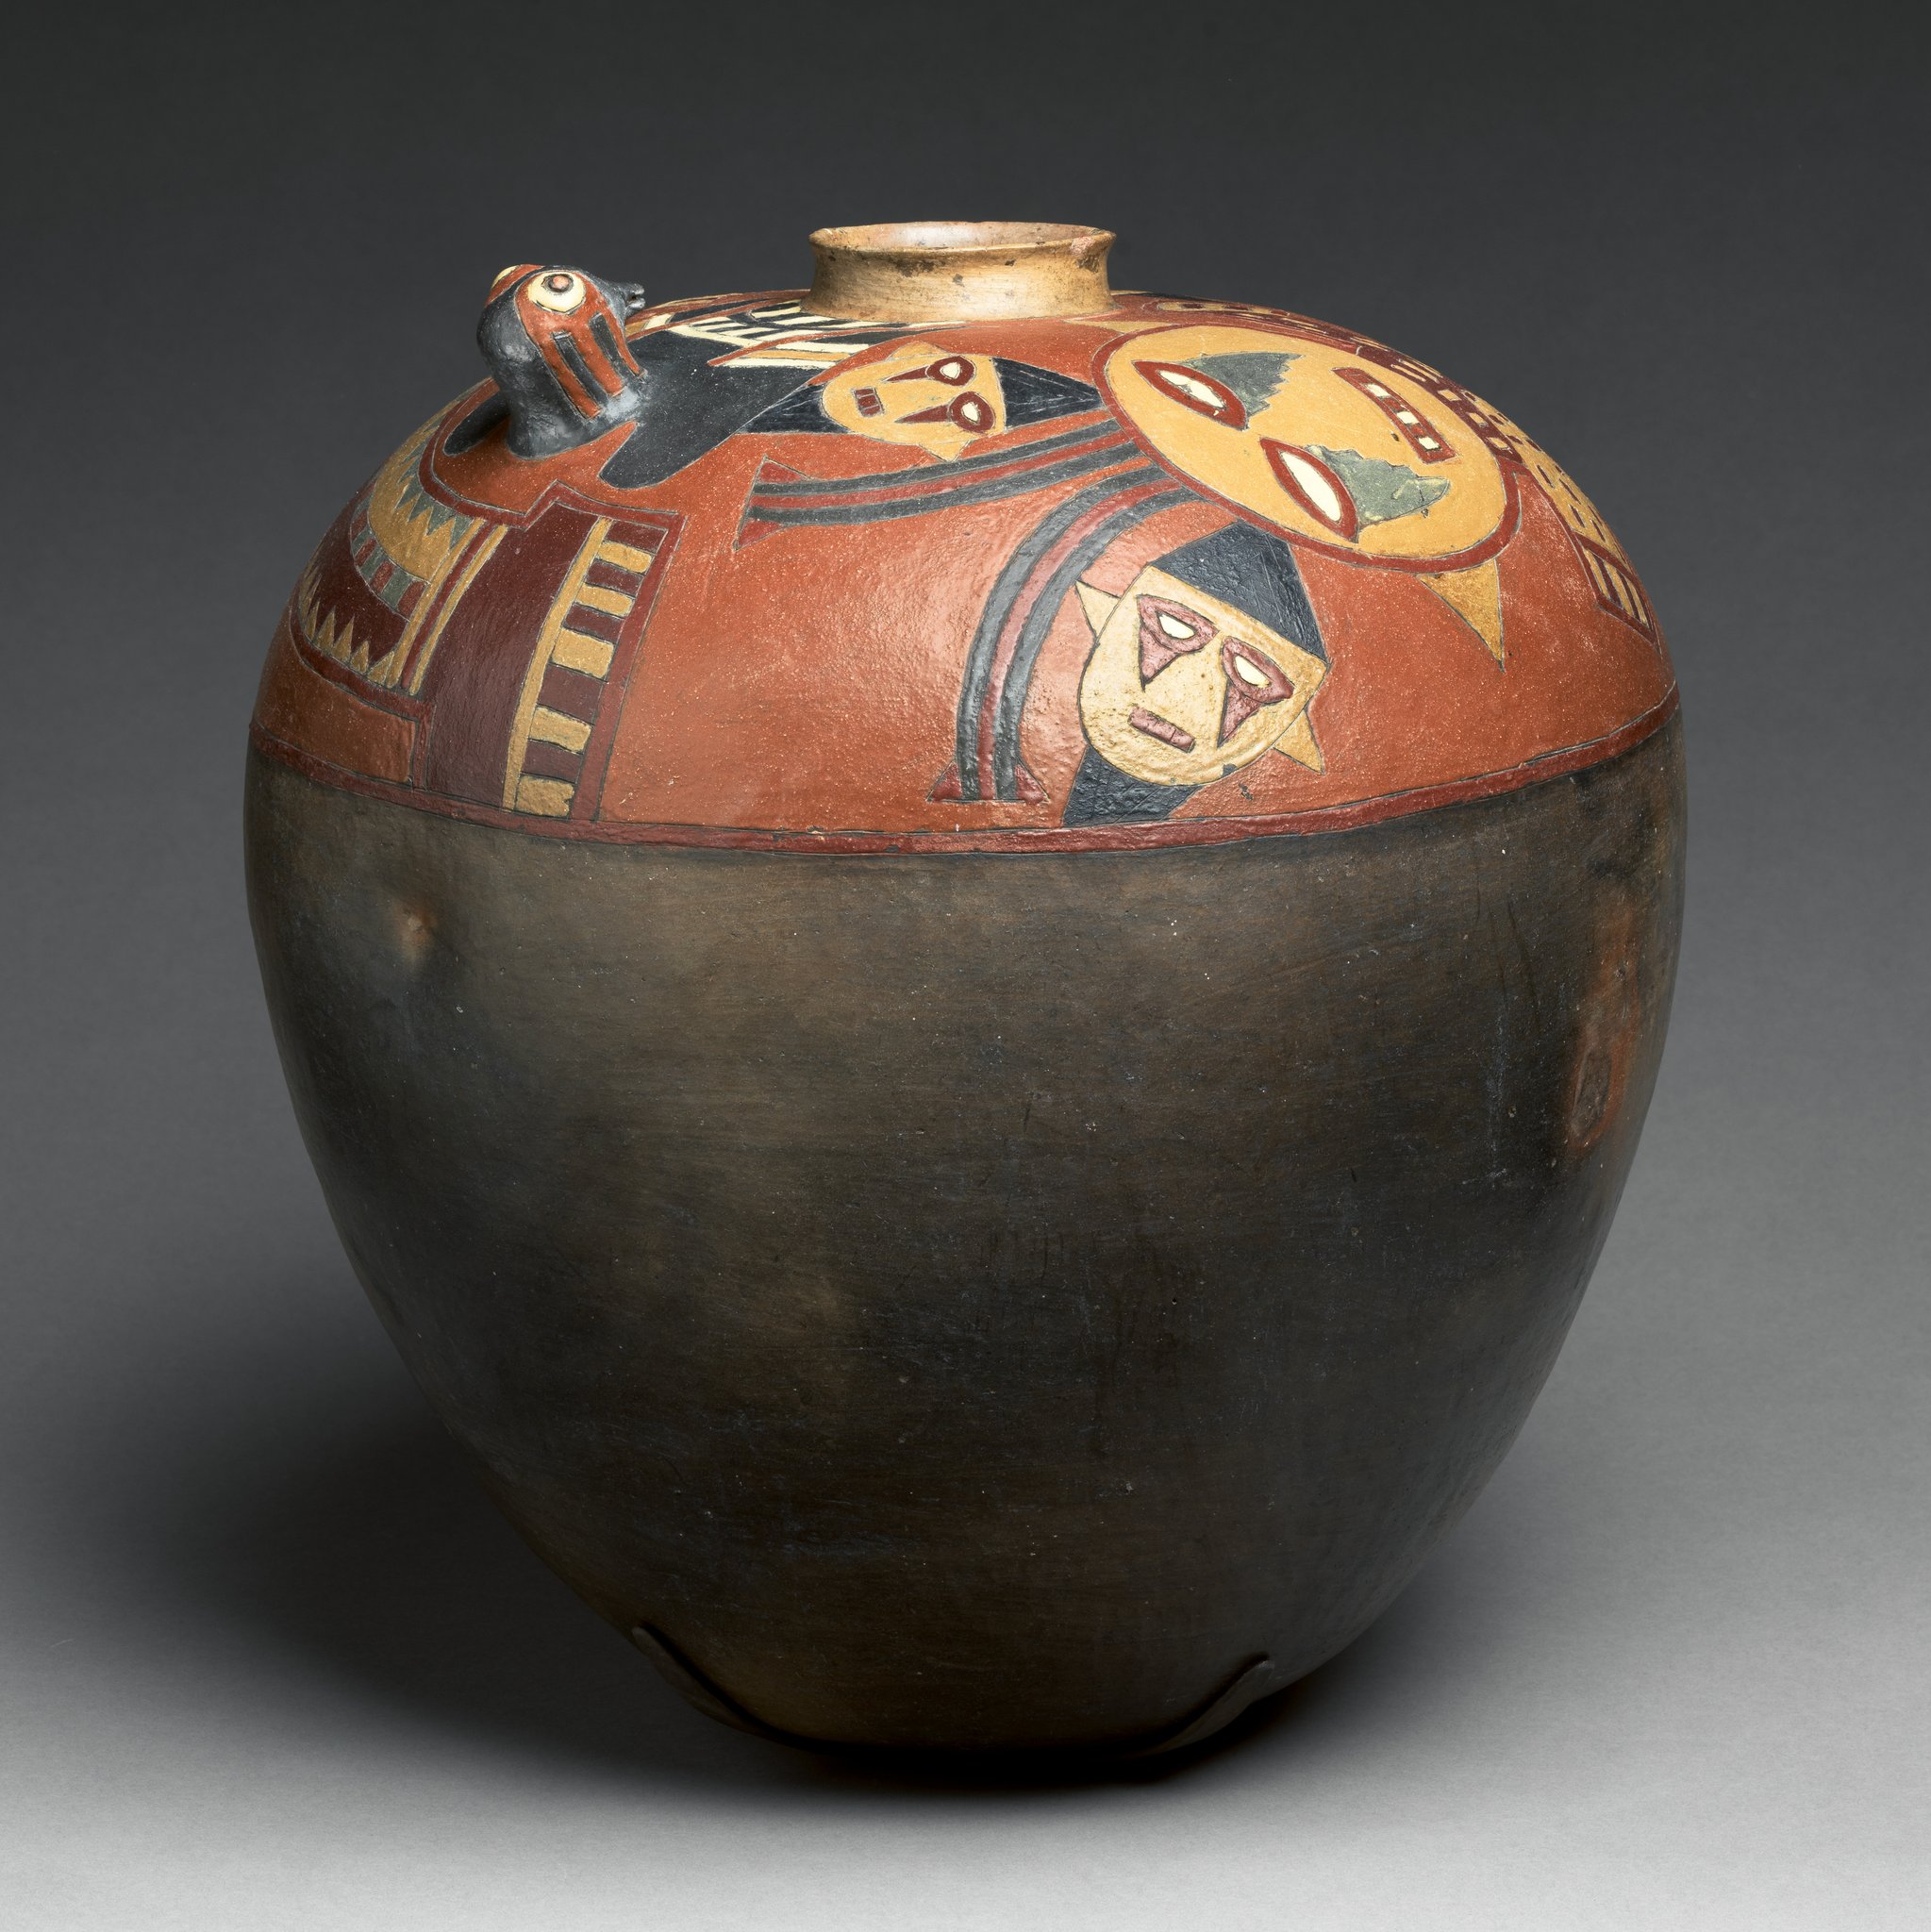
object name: jar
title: Storage jar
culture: paracas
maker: paracas artist(s)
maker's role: artist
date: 350-200 BCE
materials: ceramic, paint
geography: peru